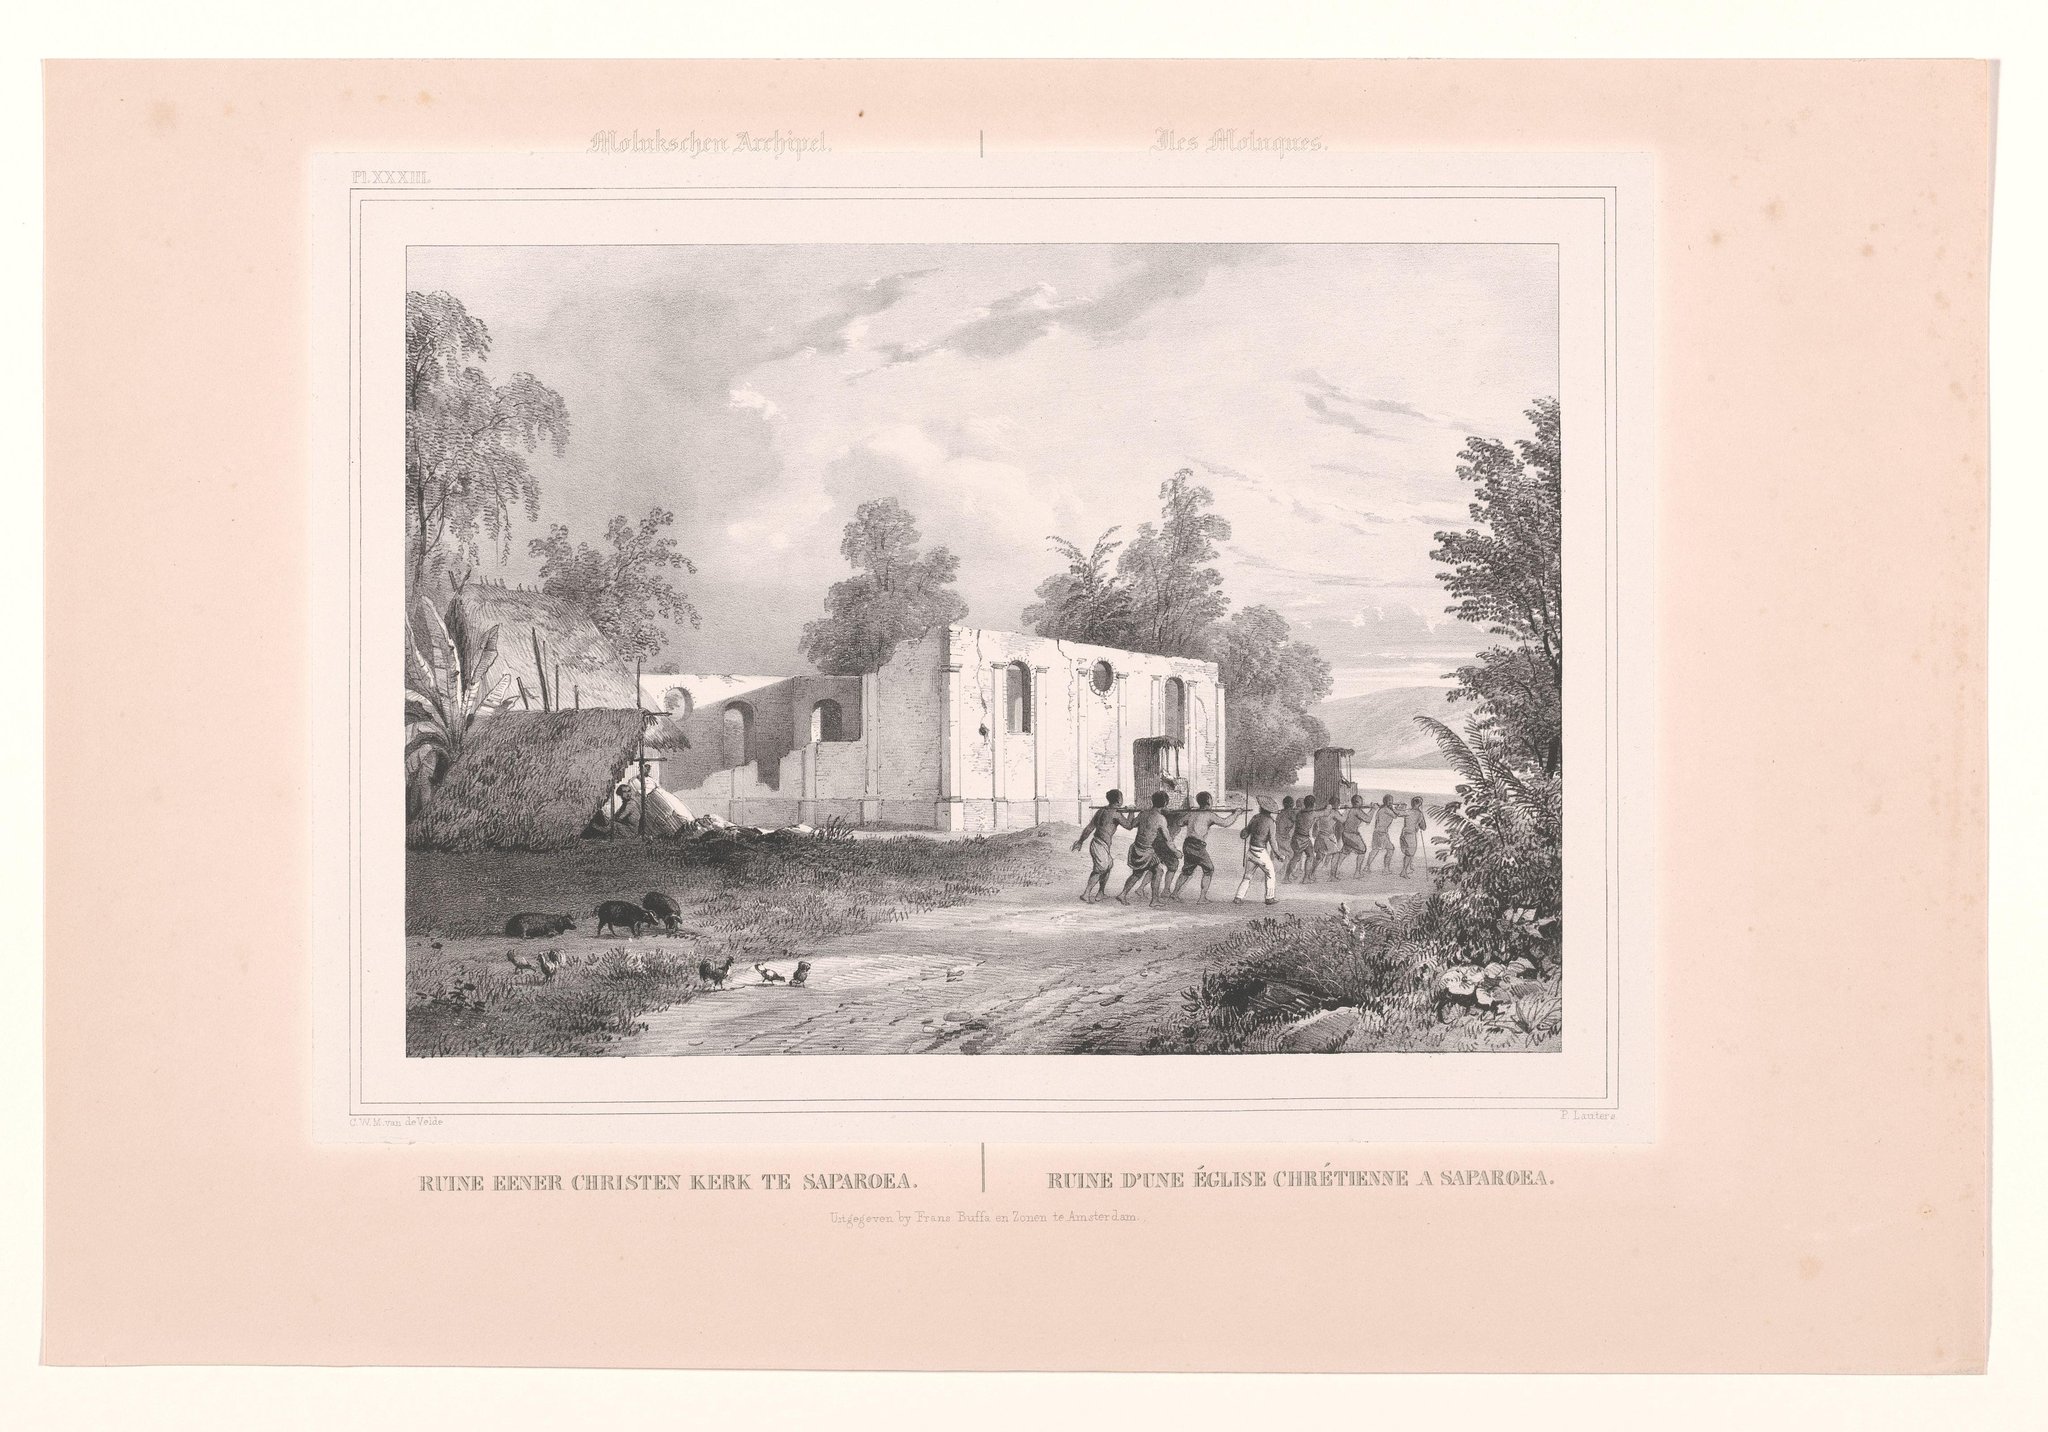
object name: print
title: Ruine eener Christen kerk te Saparoea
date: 1843-1845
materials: paper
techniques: lithograph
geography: amsterdam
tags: (carrying a person in a) sedan-chair, ruin of church, monastery, etc.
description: Voor de ruïne loopt een groep mannen met twee draagstoelen. Genummerd linksboven: Pl. XXXIII. De prent maakt deel uit van een omslag met elf bladen.